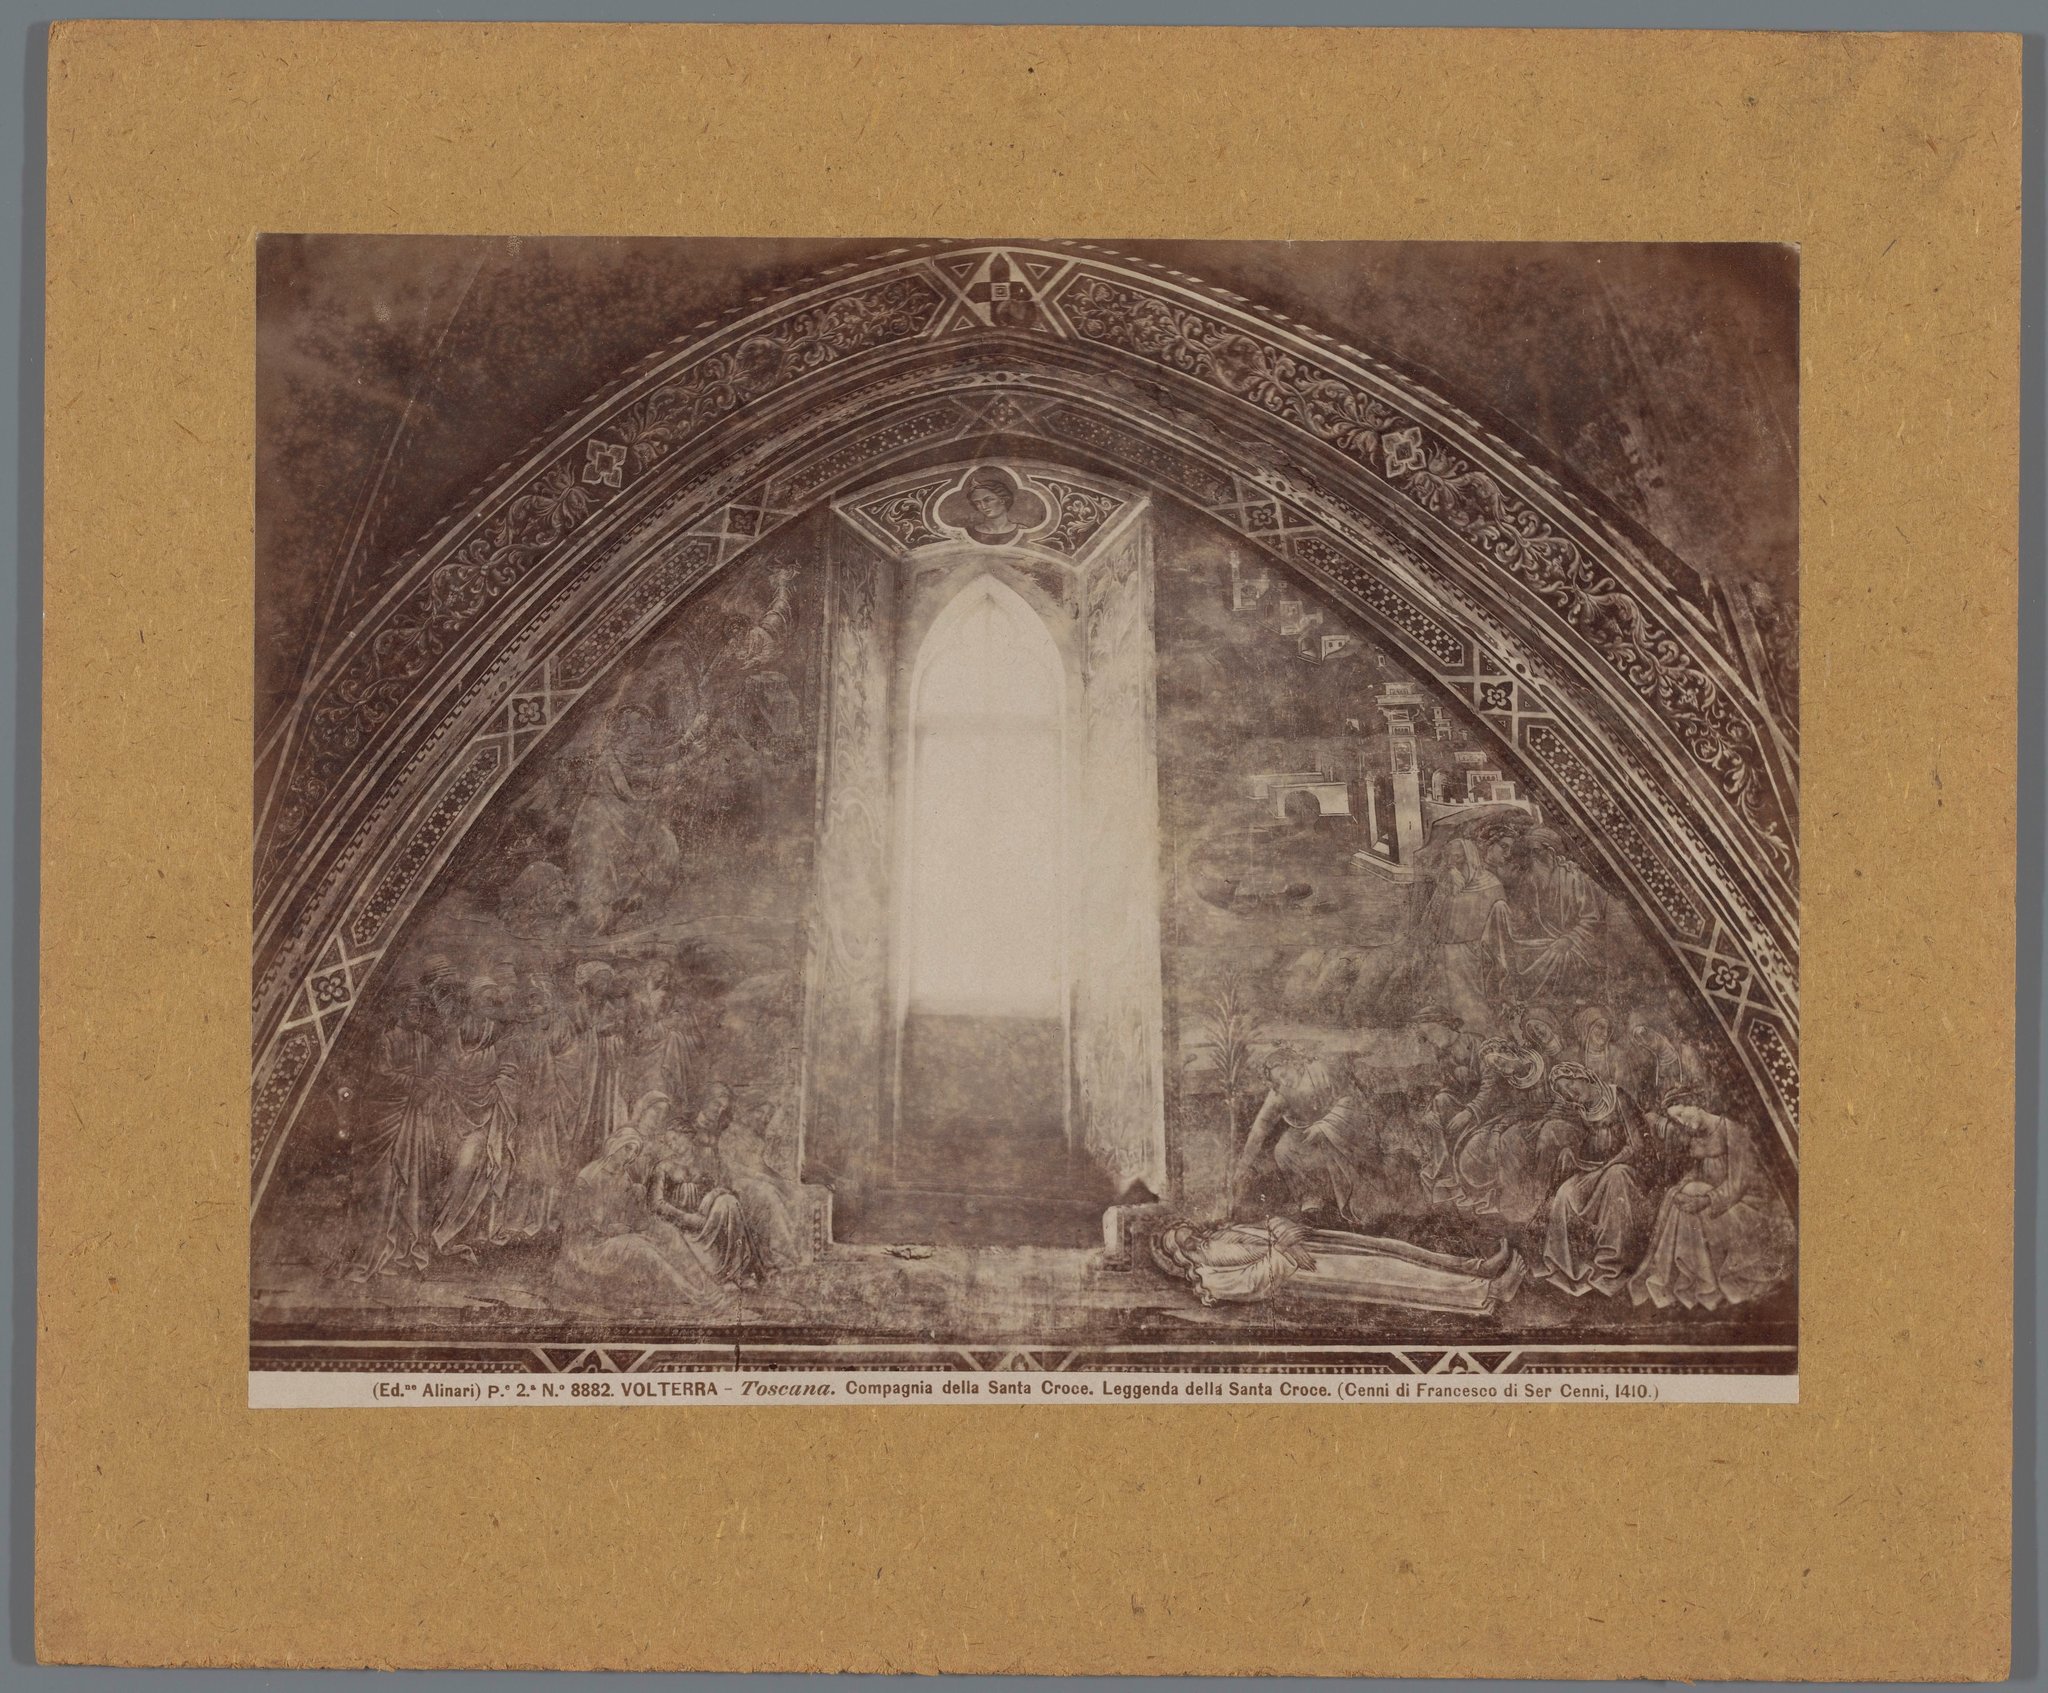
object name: photograph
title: Schildering door Cenni di Francesco in de Cappella della Croce di Giorno te Volterra, voorstellend de legende van het Heilige kruis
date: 1875-1900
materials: cardboard, photographic support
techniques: albumen print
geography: chiesa di san francesco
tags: painting (including book-illumination, miniature-painting) (+ plaster ~ arts), 11d4111 seth puts a branch from the tree of knowledge on adam's grave ~ legend of the true cross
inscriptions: collector's mark: Lugt 3937, number: ‘P.e 2.a N.o 8882.’